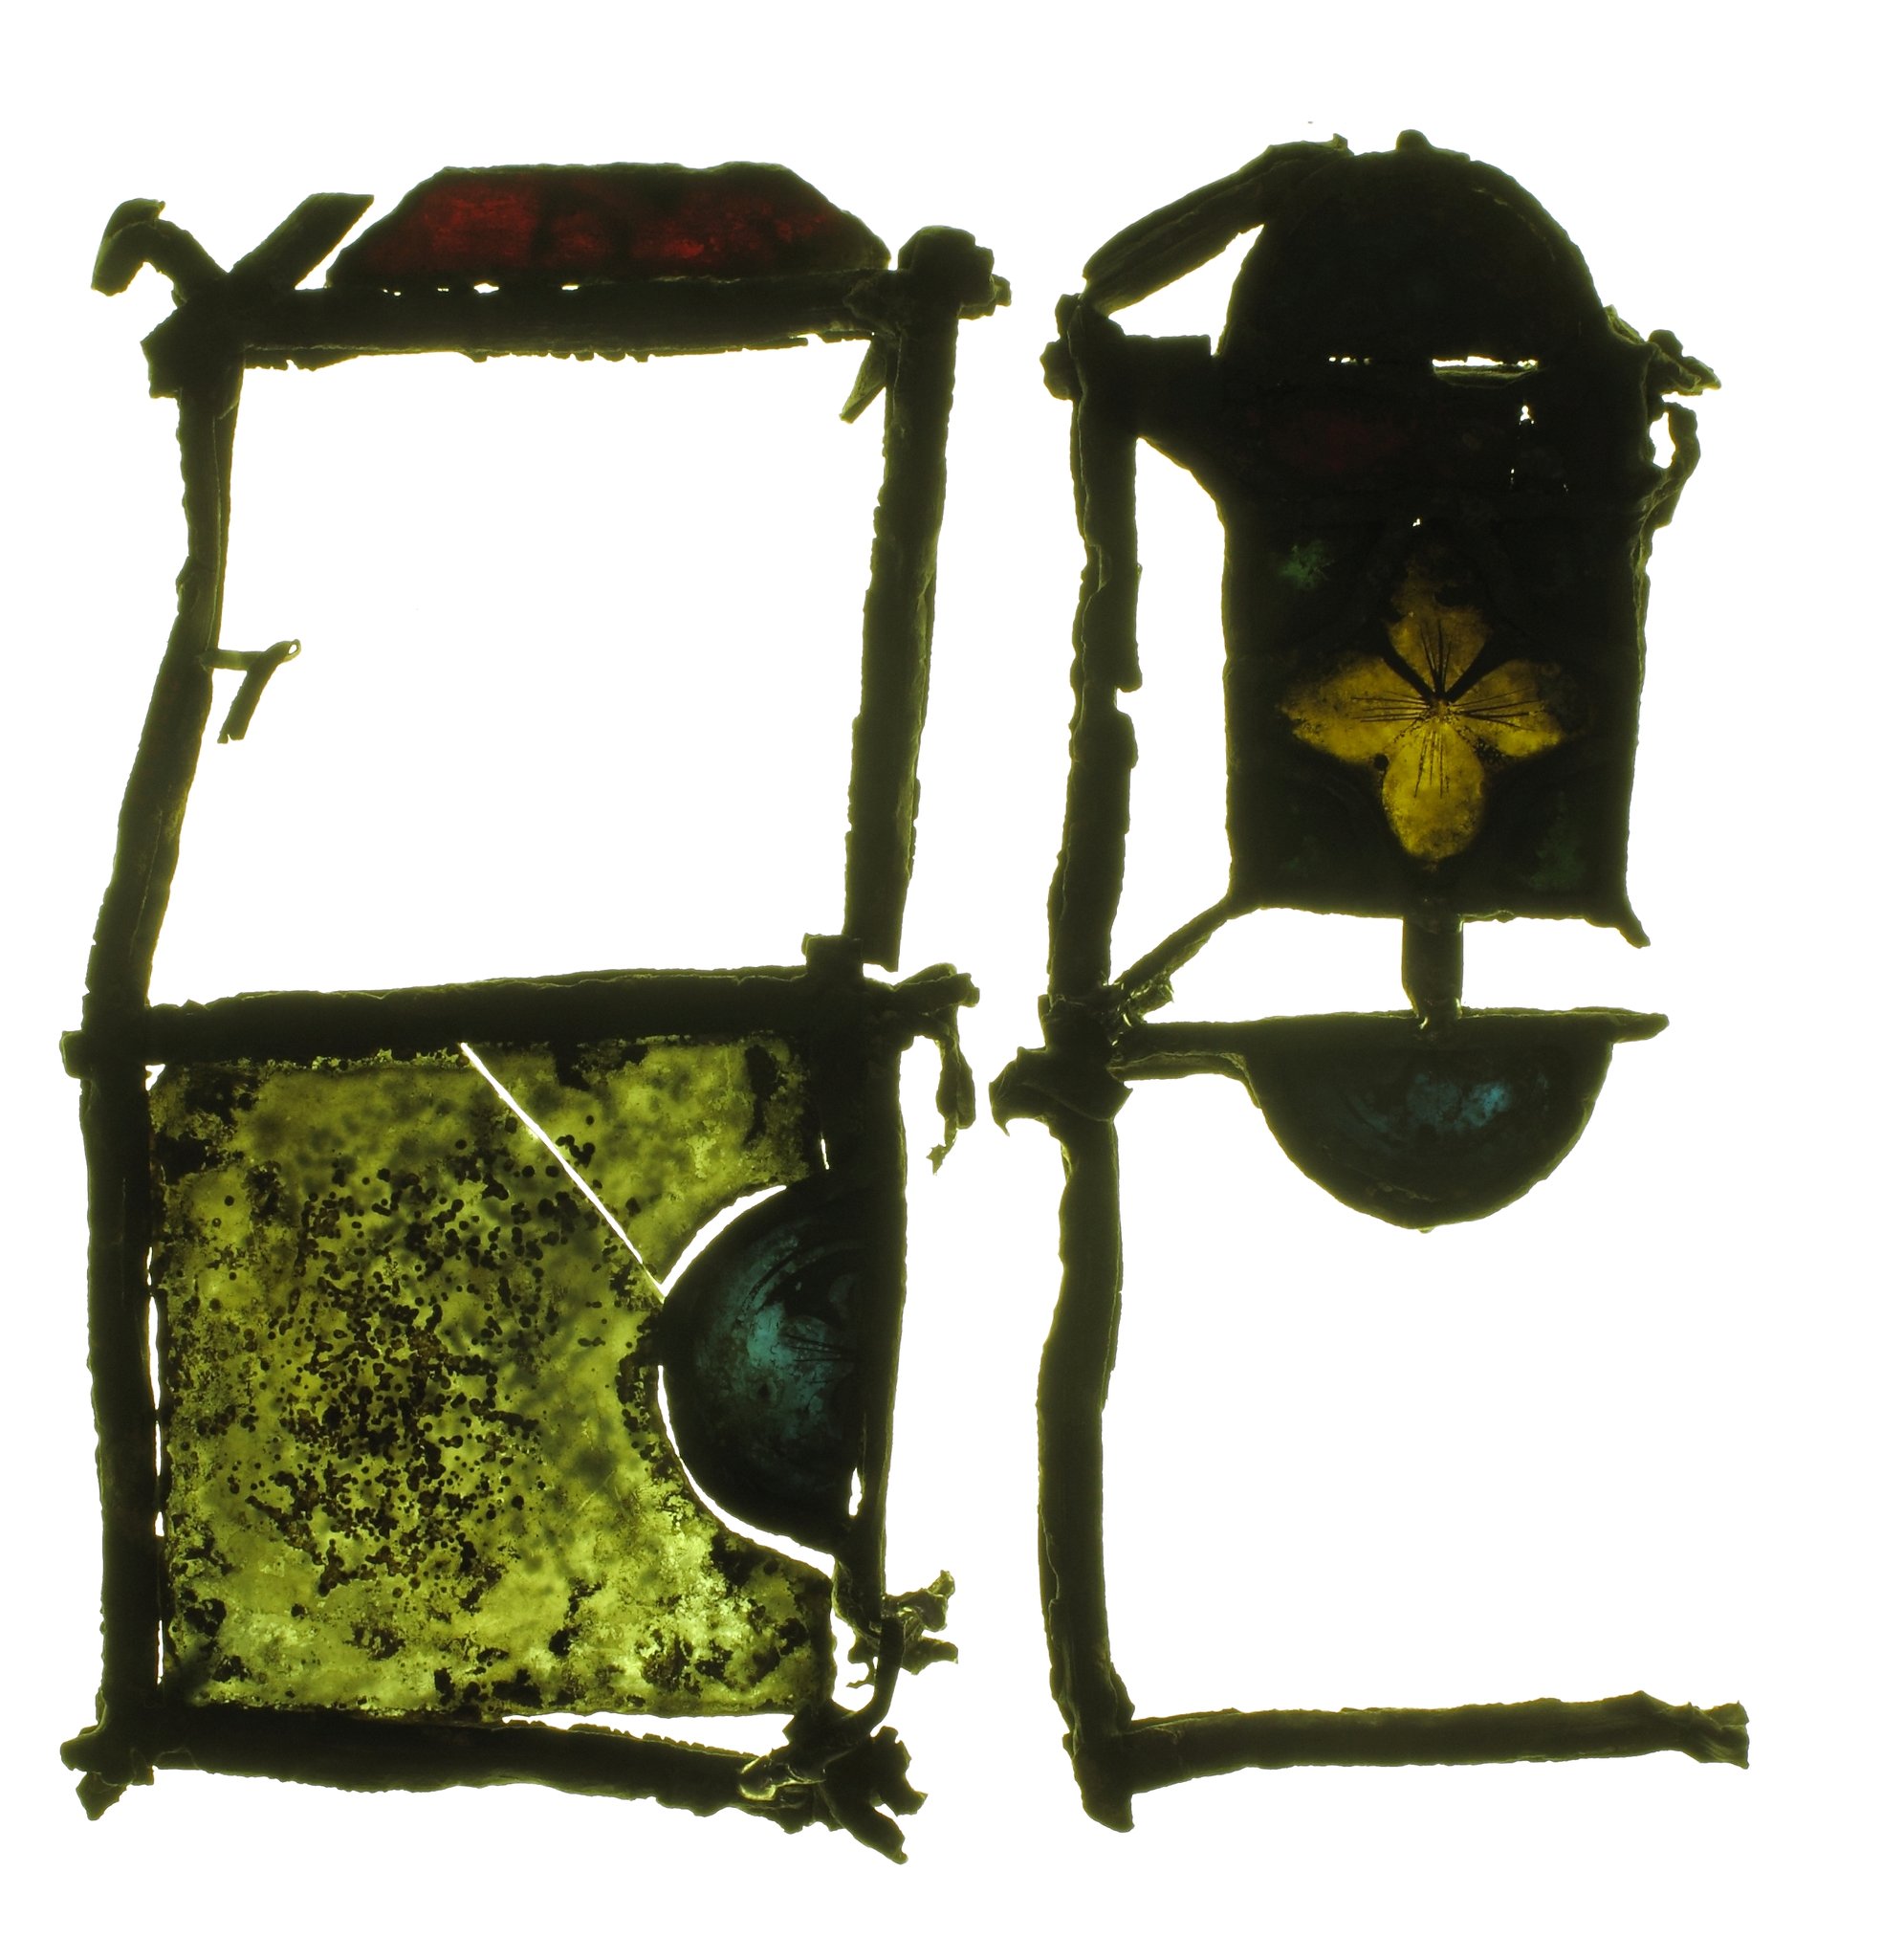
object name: fragment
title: Glass Fragment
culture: french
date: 1301-1400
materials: glass, metal